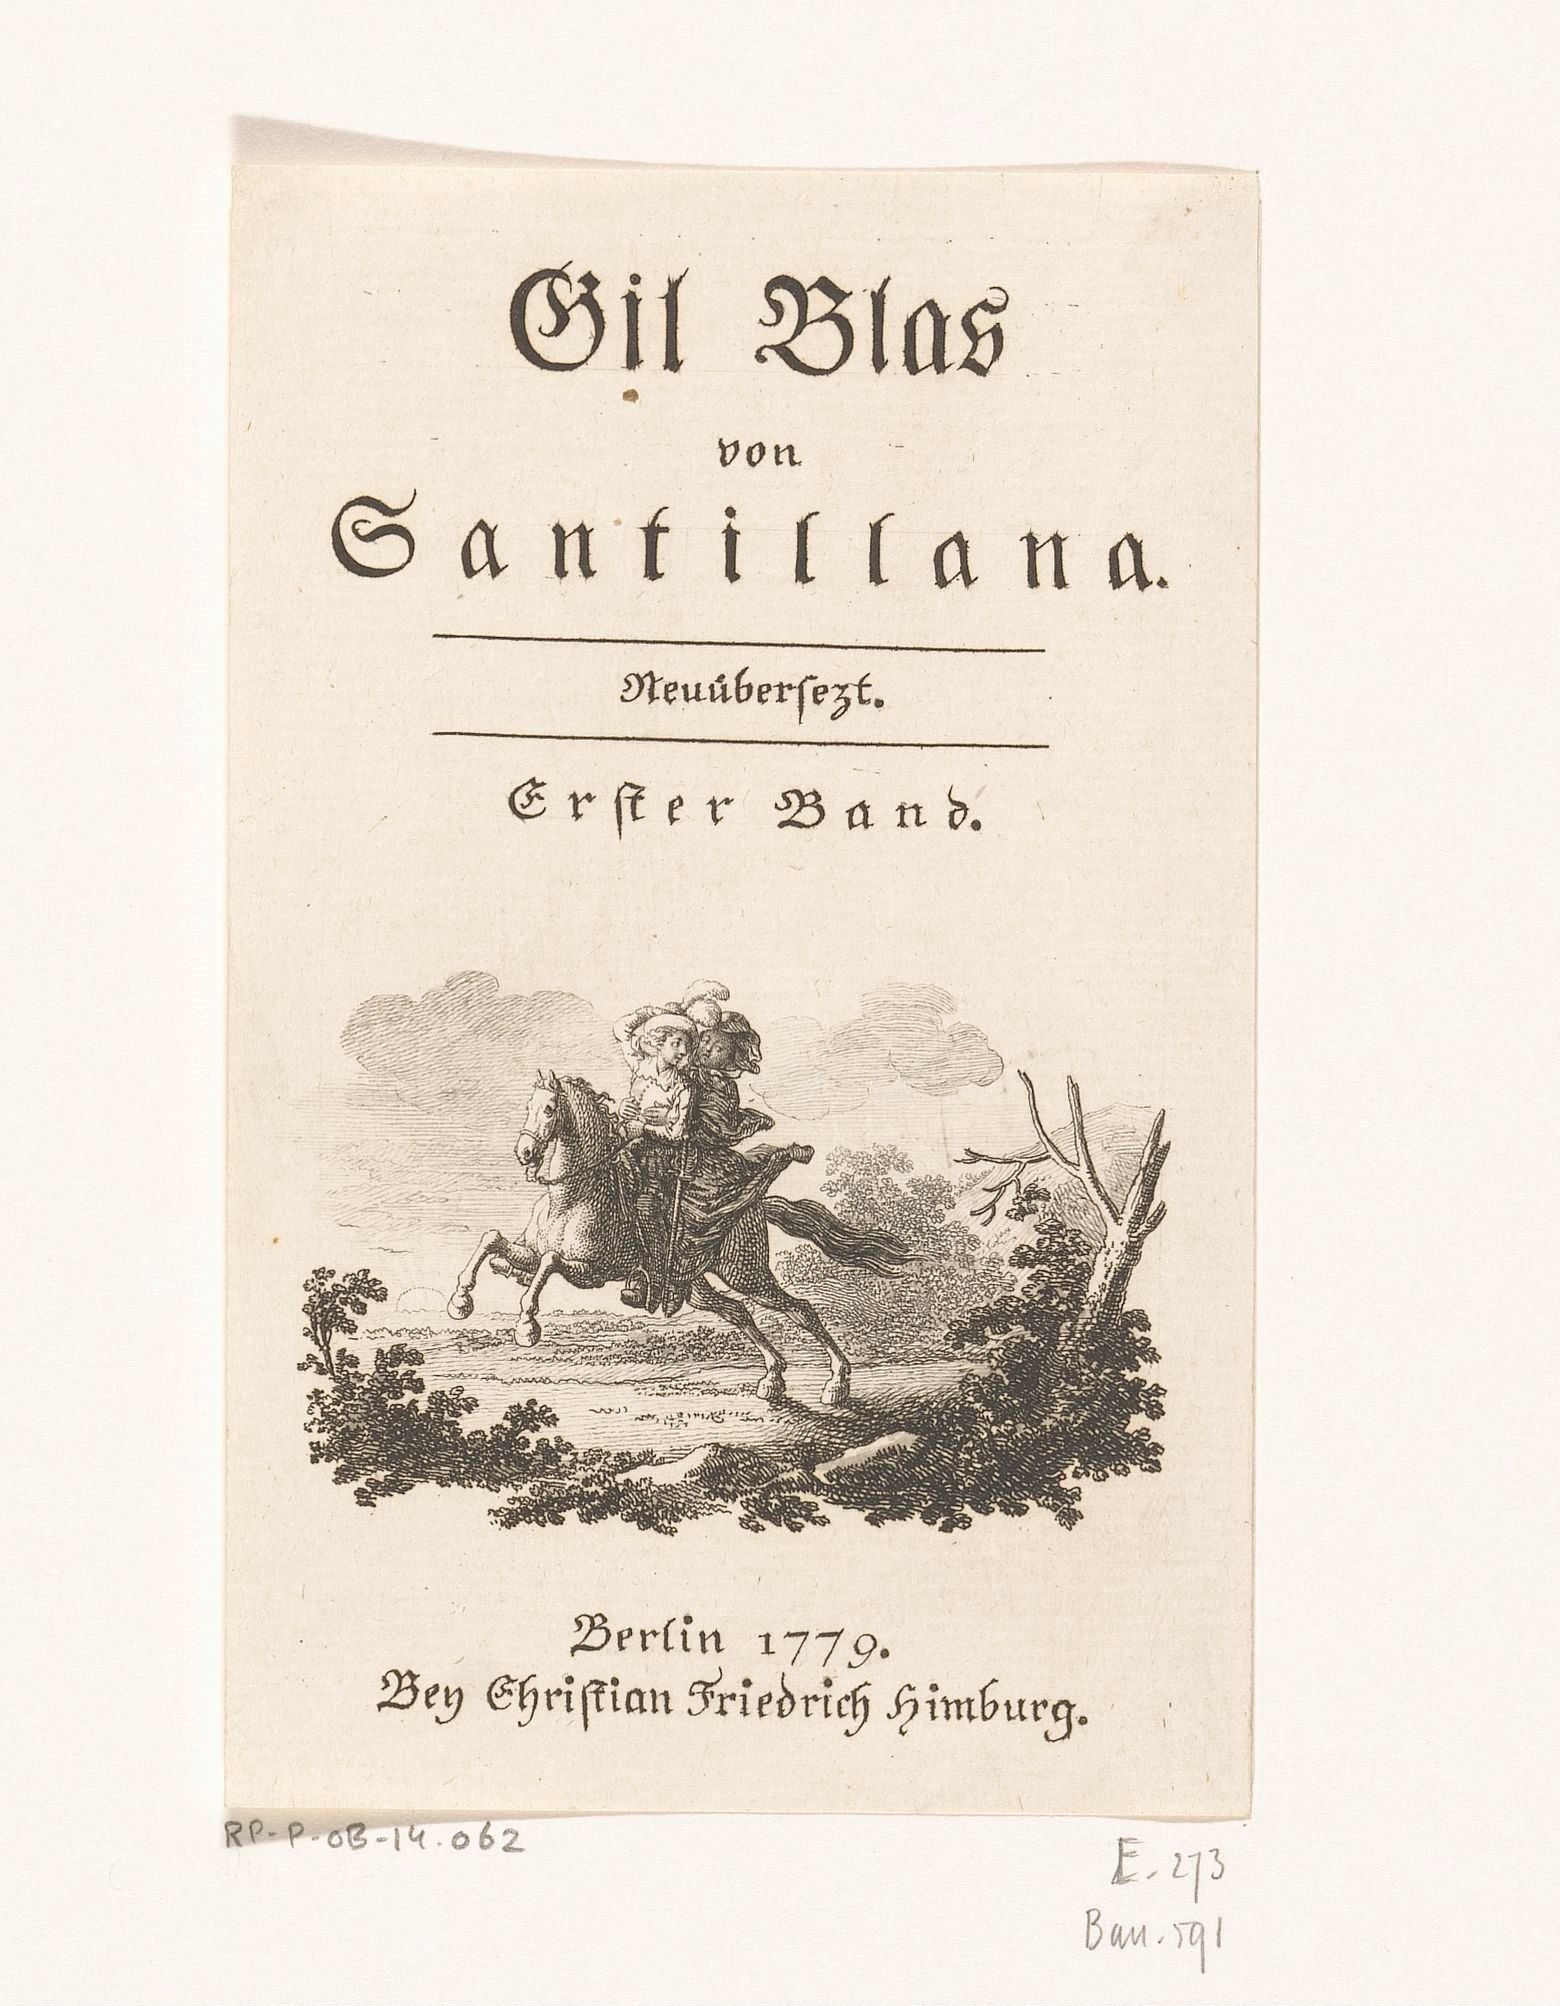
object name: print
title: Gil Blas en Donna Mencia te paard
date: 1778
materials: paper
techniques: etching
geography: berlin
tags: literature, horse in motion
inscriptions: collector's mark: Lugt 2228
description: Deze prent maakt deel uit van een serie van twaalf voorstellingen die de geschiedenis van 'Gil Blas' illustreren. Titelpagina voor: Alain-René Lesage. Gil Blas von Santillana. Neu übersetzt [door Wilhelm Christhelf Sigmund Mylius]. 6 dln. Berlijn: Christian Friedrich Himburg, 1779, dl. 1.